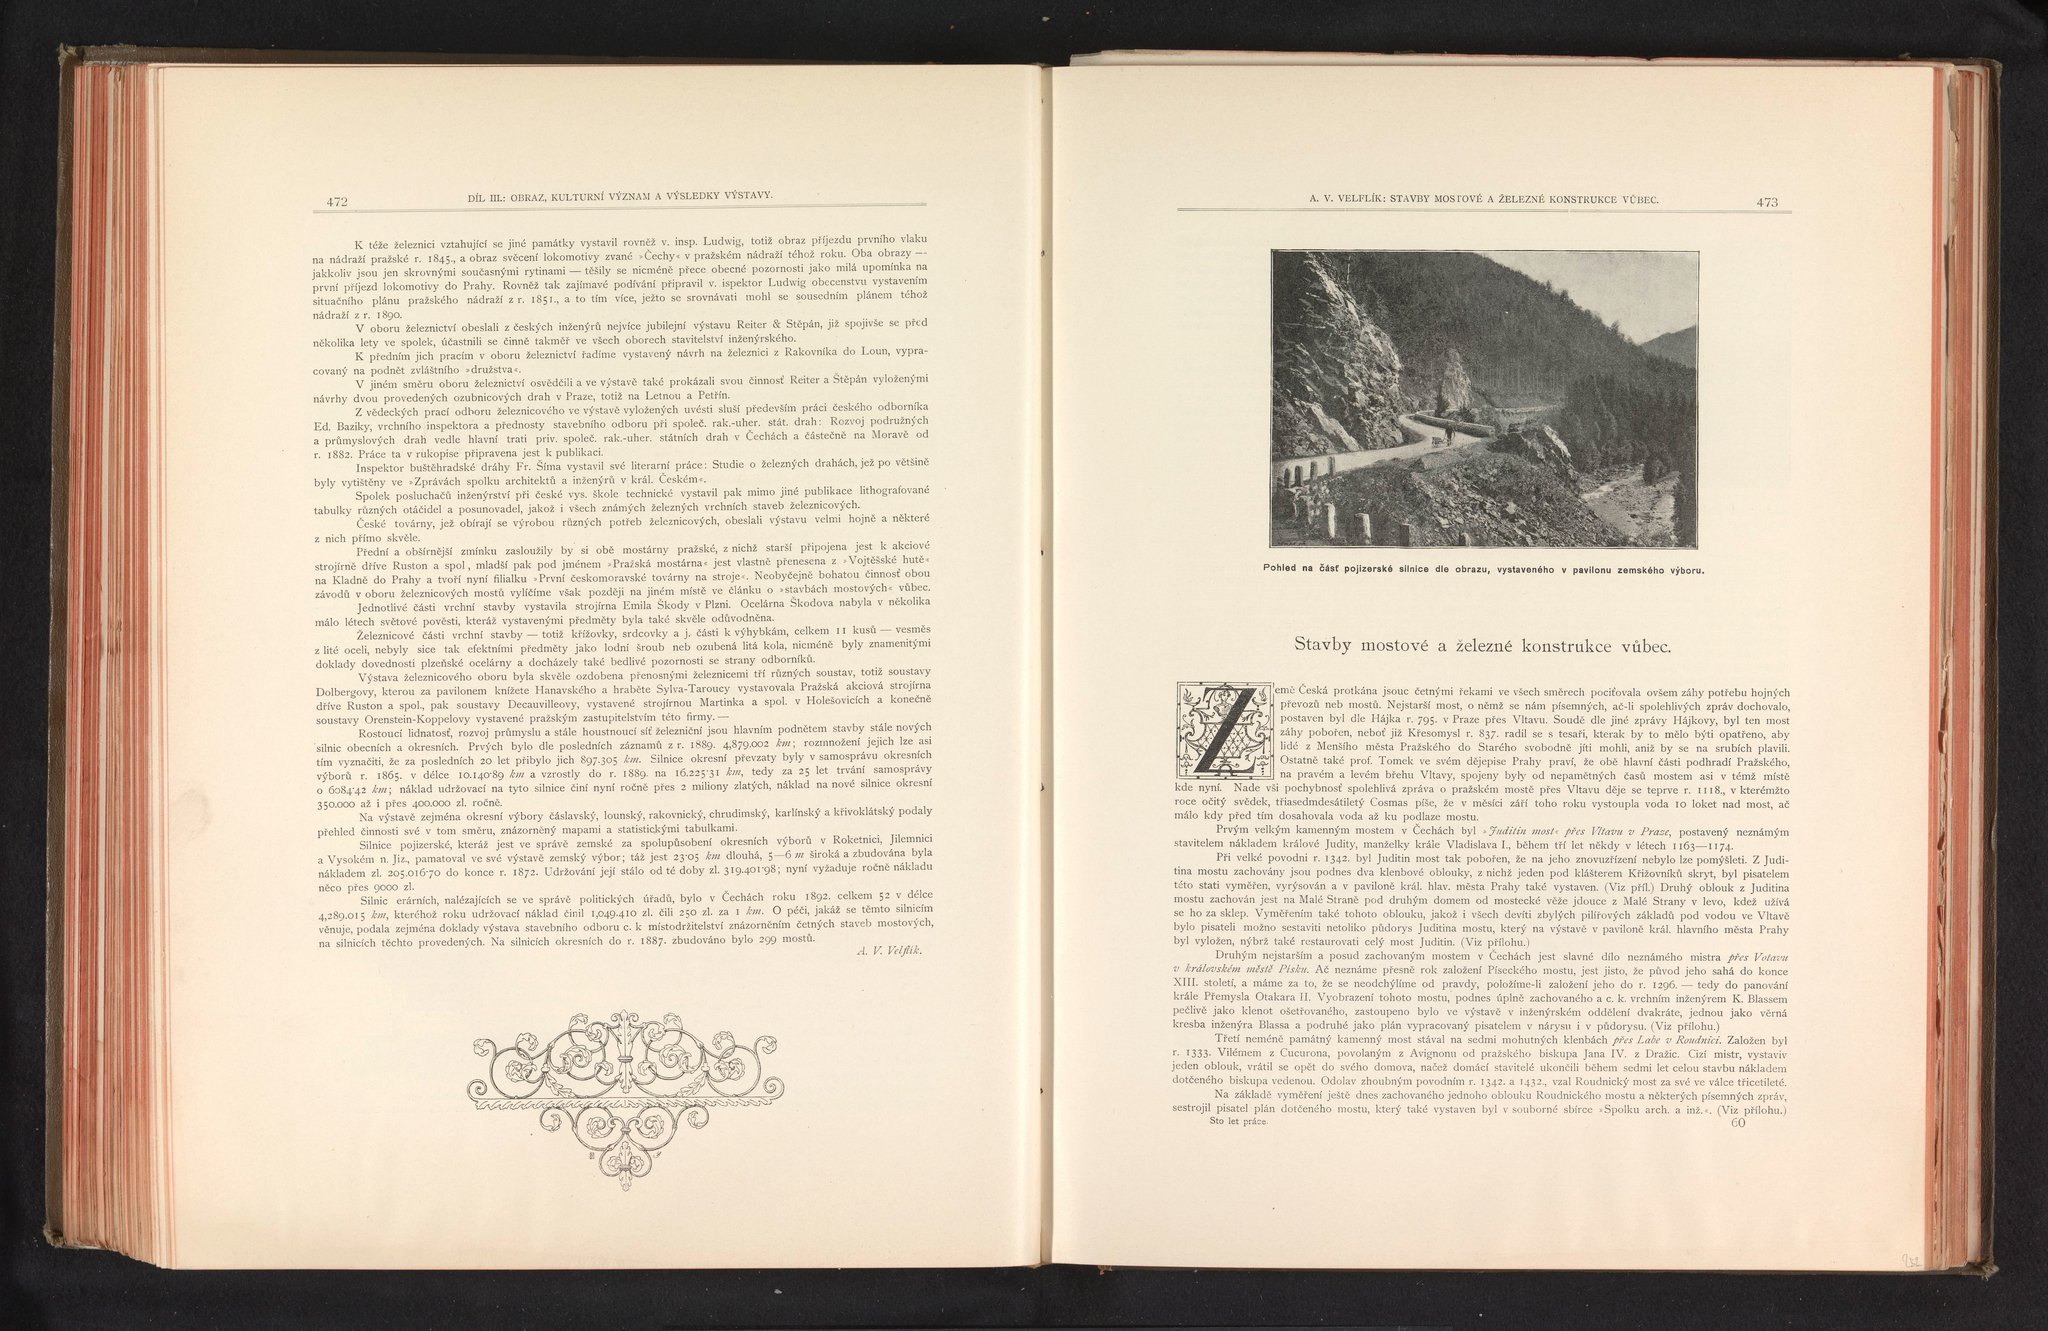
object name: photomechanical print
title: Pohled na cast pojizerské slinice dle obrazu, vystaveného v pavilonu zemského výboru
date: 1891-1895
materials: paper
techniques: autotype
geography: czech republic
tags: public road, mountains